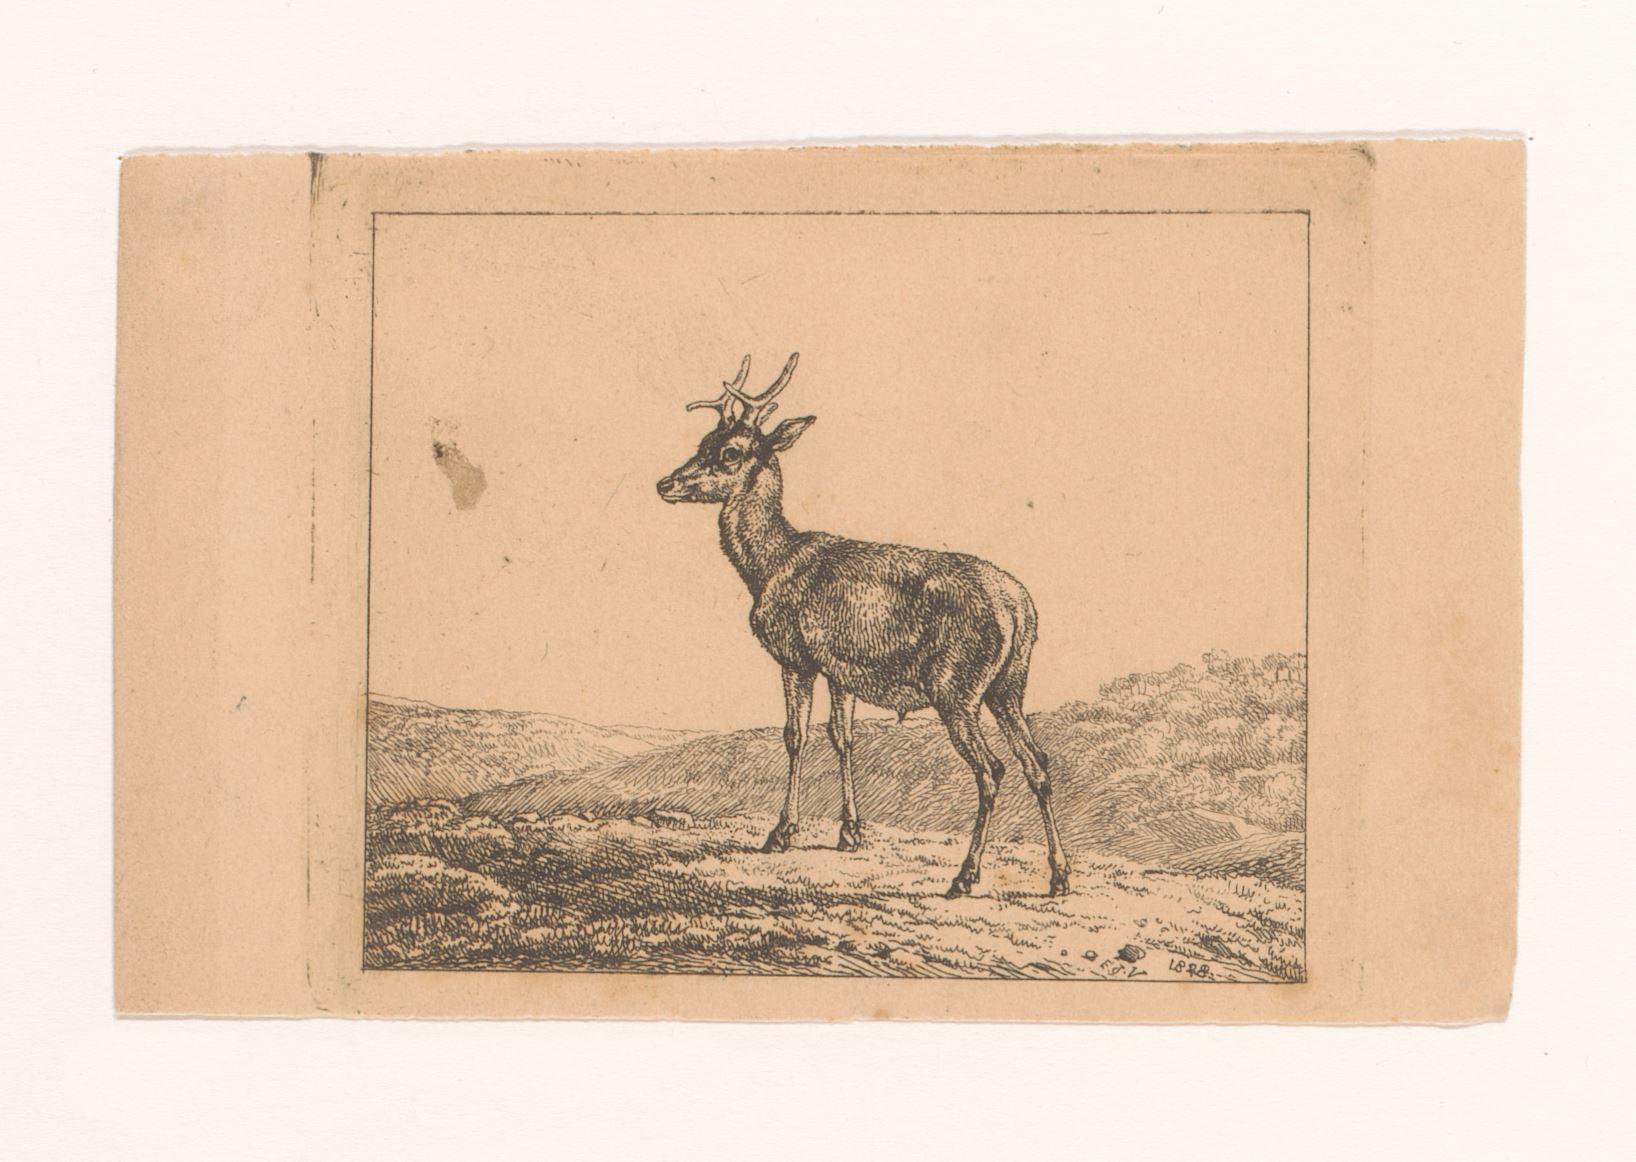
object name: print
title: Hert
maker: eugène verboeckhoven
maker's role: draughtsman, painter, print maker, printer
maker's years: 1798-1881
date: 1828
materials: paper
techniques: drypoint, etching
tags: hoofed animals: deer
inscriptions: date